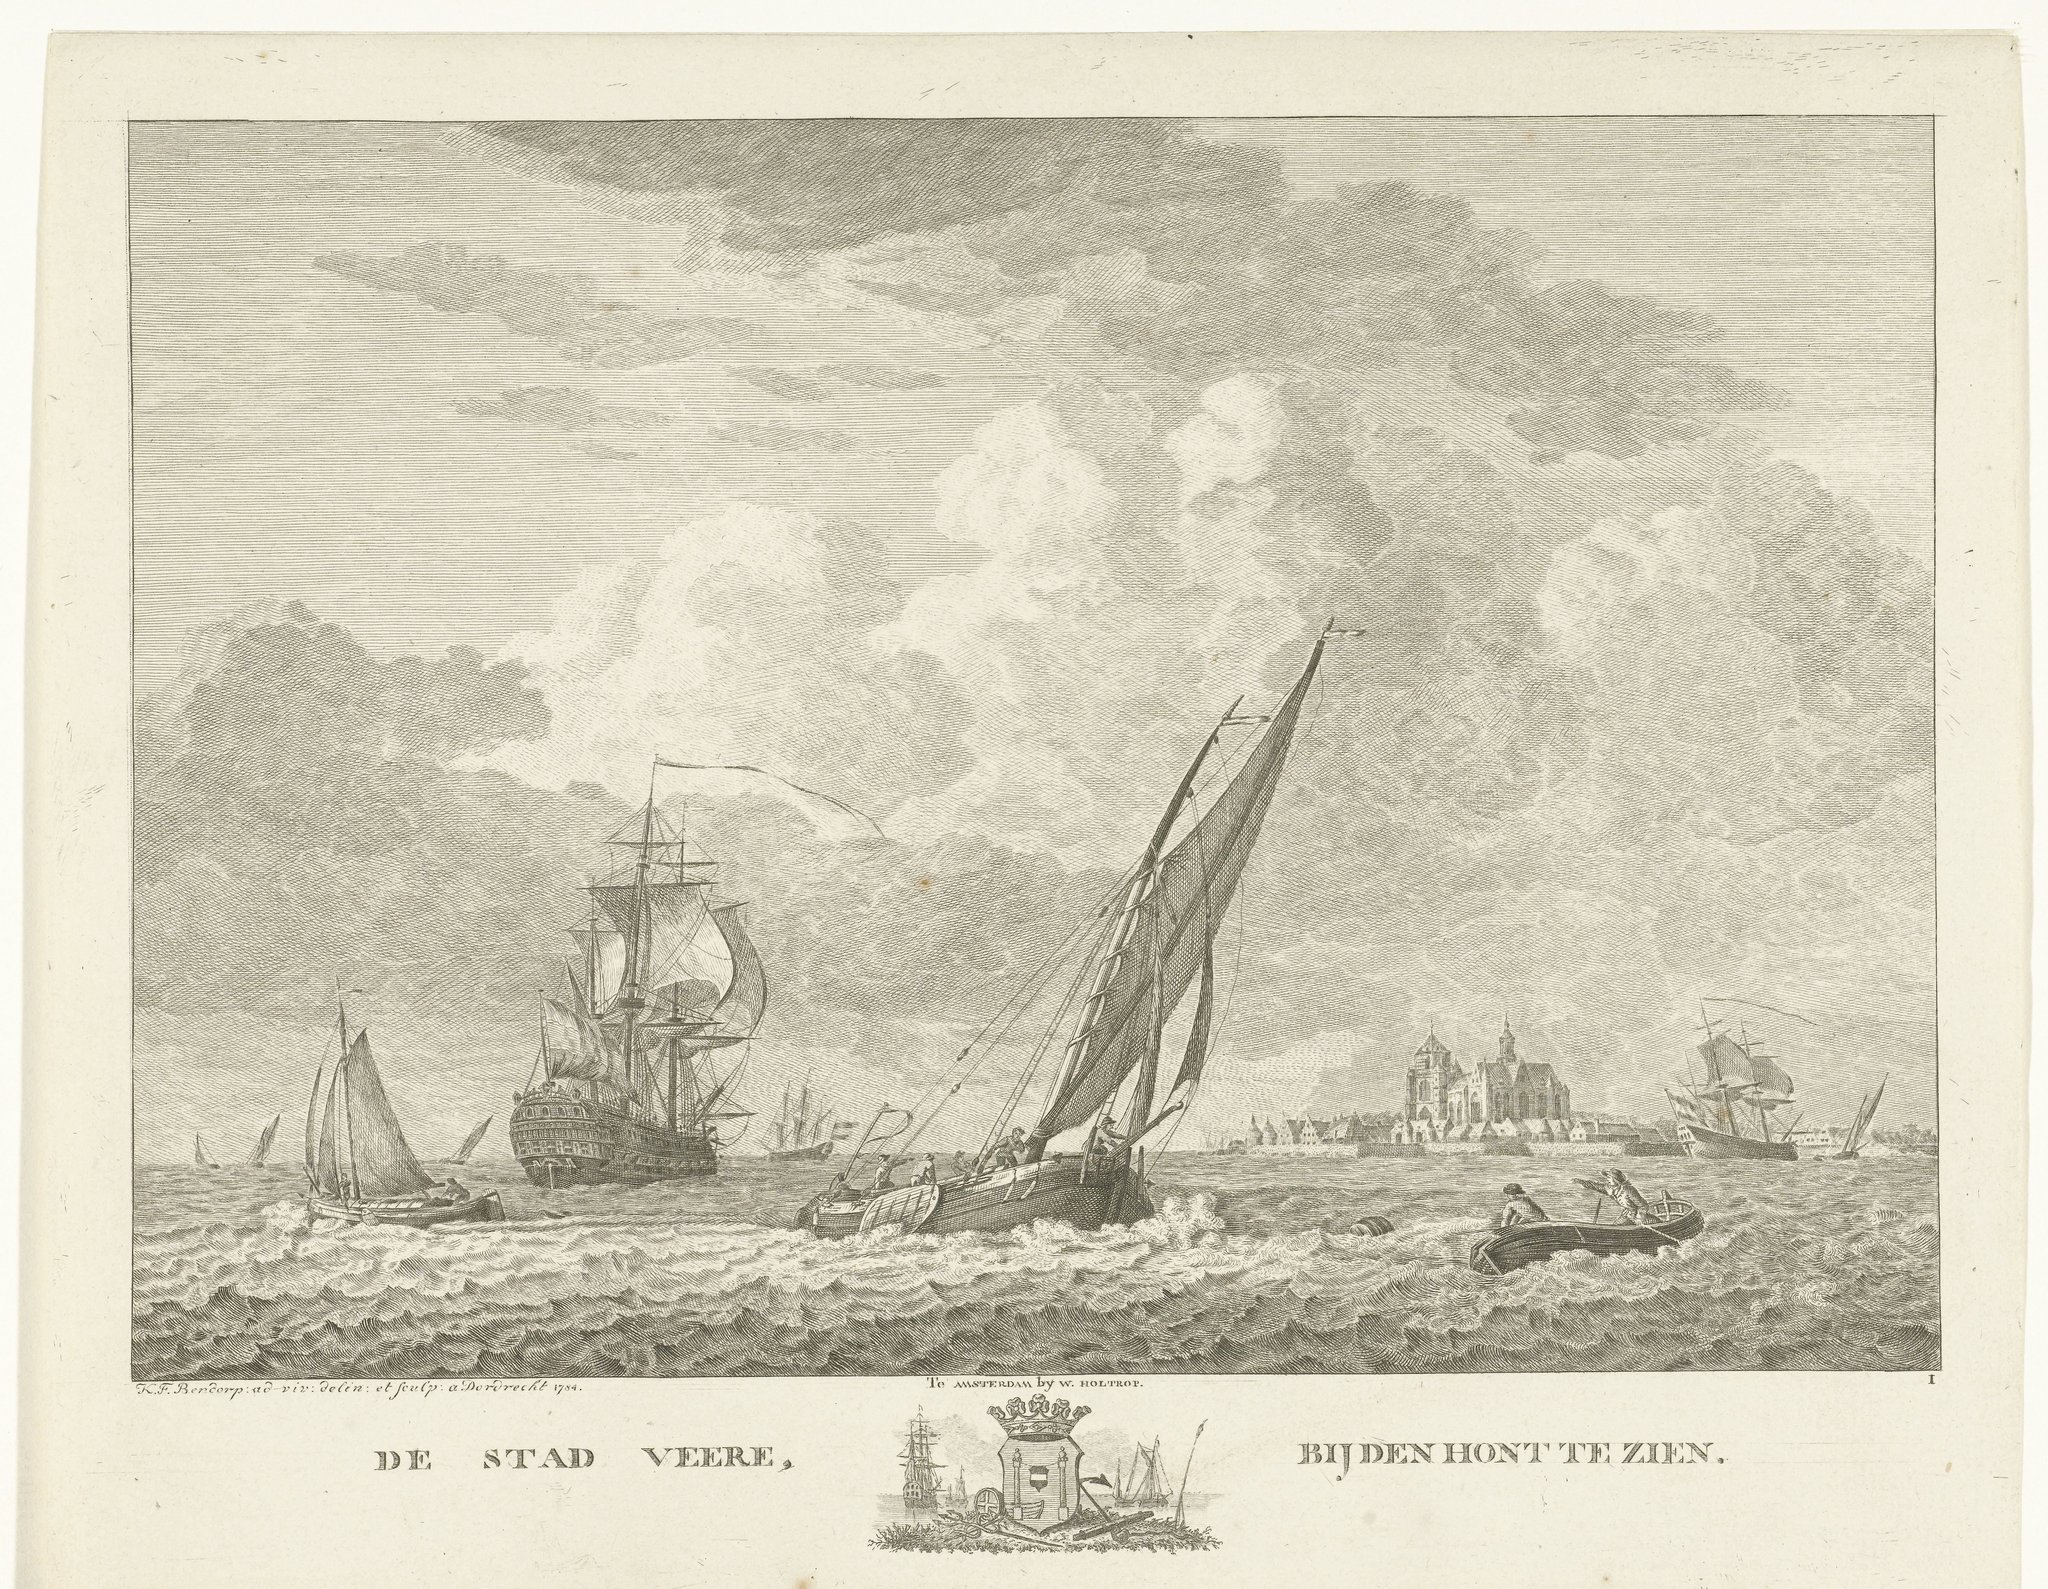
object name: print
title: De stad Veere, bij den Hont te zien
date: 1784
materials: paper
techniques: engraving, etching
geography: dordrecht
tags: sailing-ship, sailing-boat, church (exterior), rowing-boat, canoe, etc., prospect of city, town panorama, silhouette of city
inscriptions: collector's mark: Lugt 2228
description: Gezicht op Veere, gezien vanaf de Westerschelde (vroeger ook wel de Hont genoemd). Onder in het midden het wapen van de stad. Rechts, onder de voorstelling genummerd: I.